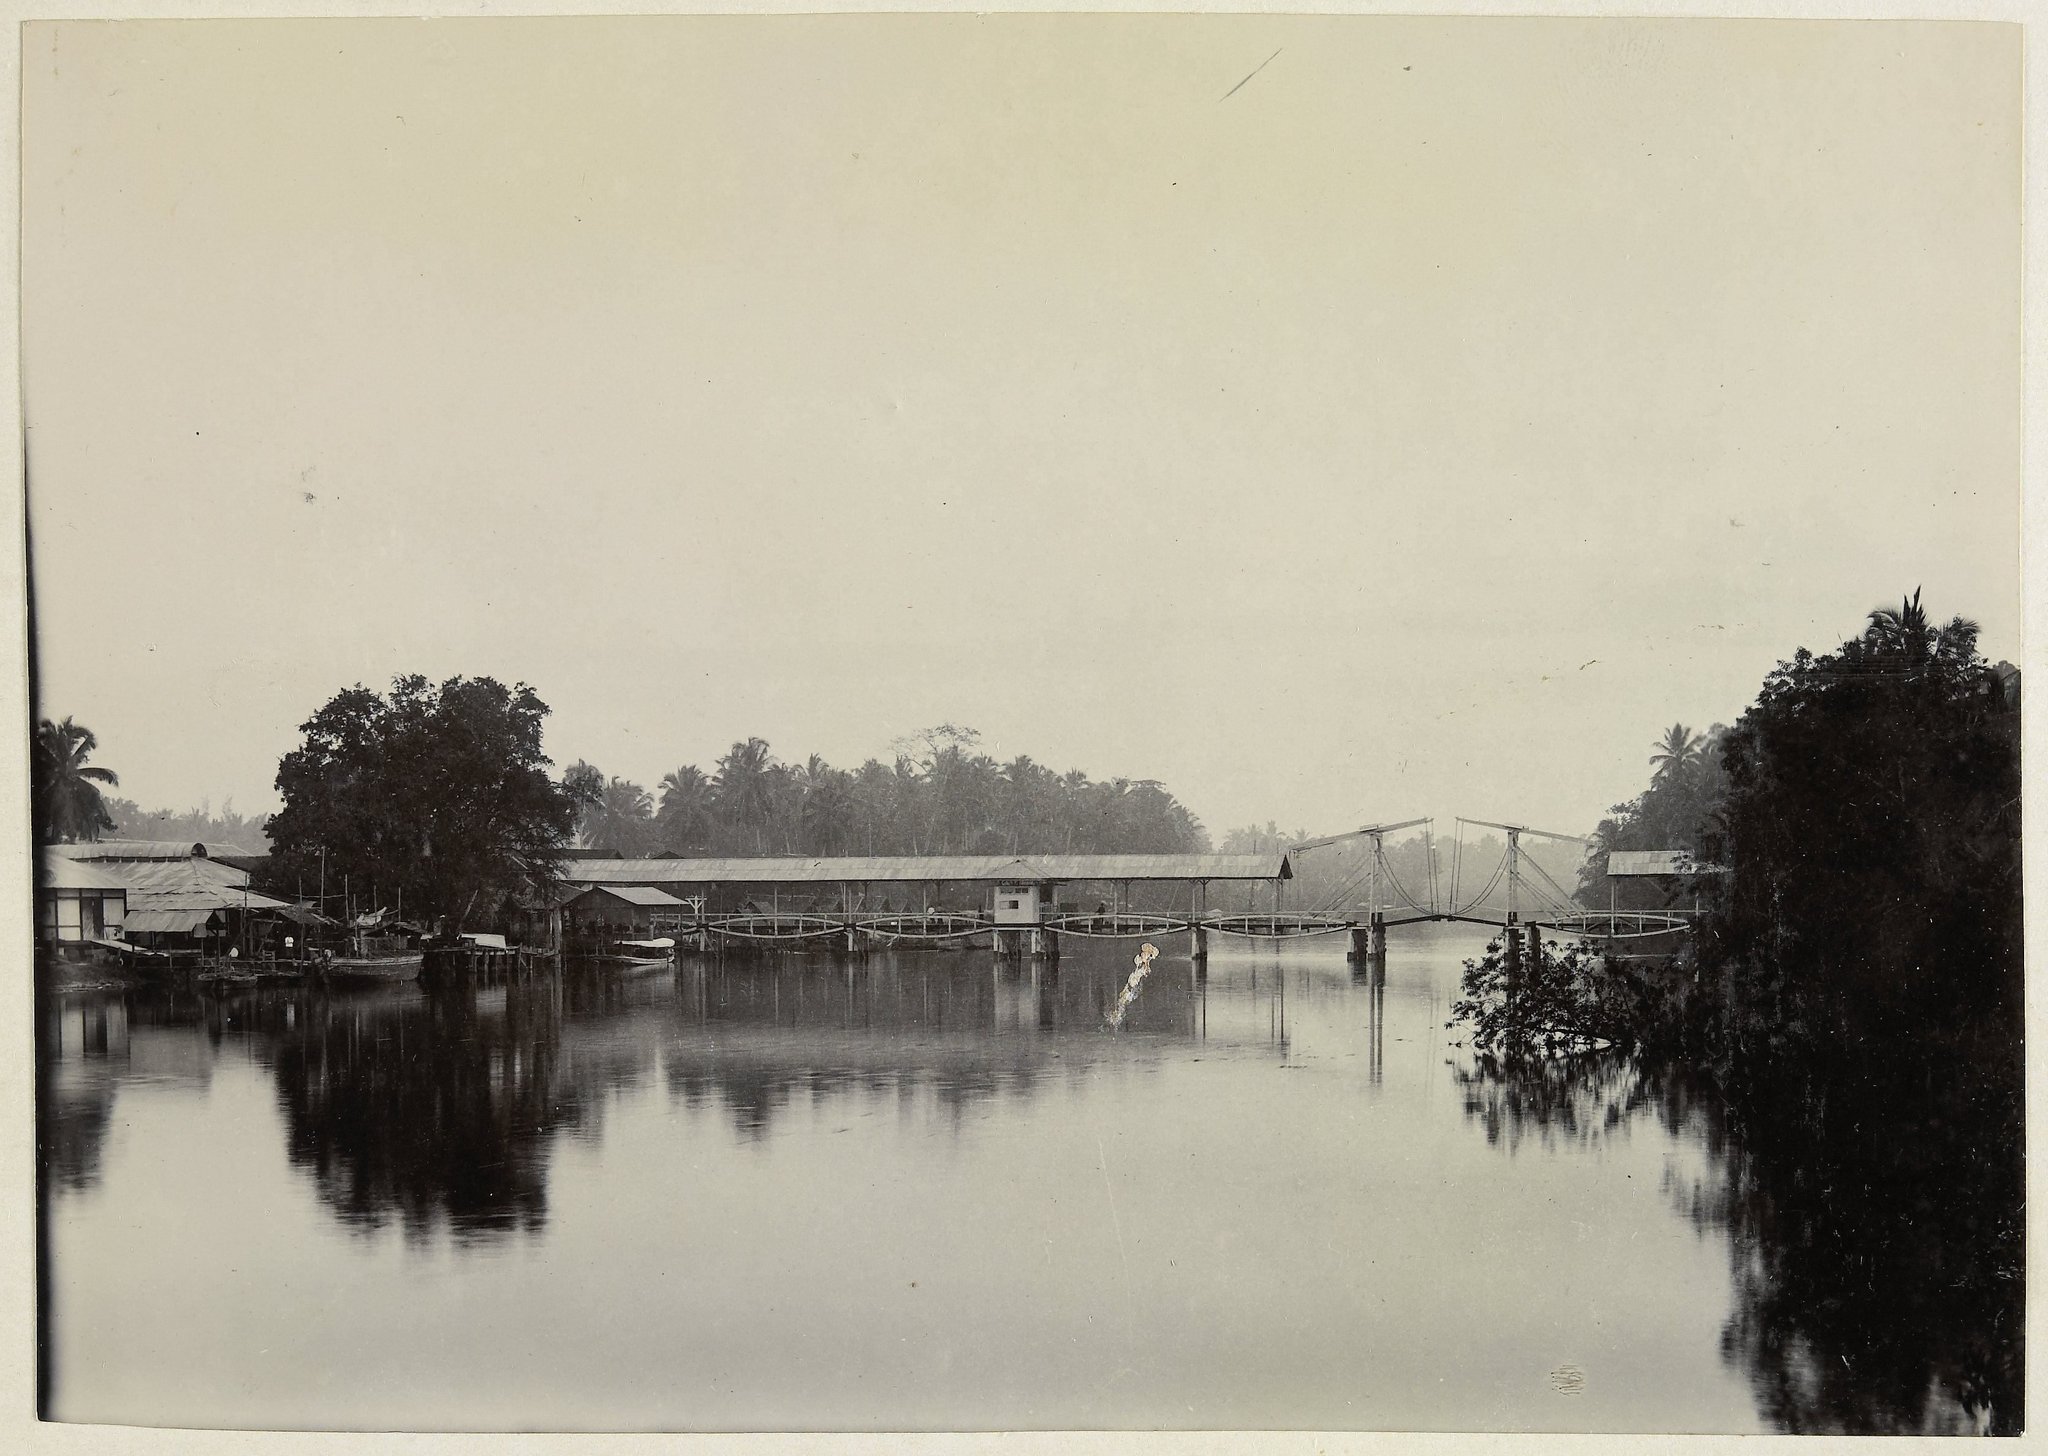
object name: photograph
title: Gezicht op de Sandelbrug in de Wampoe rivier, Tandjong Poera, Langkat Sumatra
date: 1890-1900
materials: cardboard, paper, photographic support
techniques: gelatin silver print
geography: bindjai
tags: sumatra